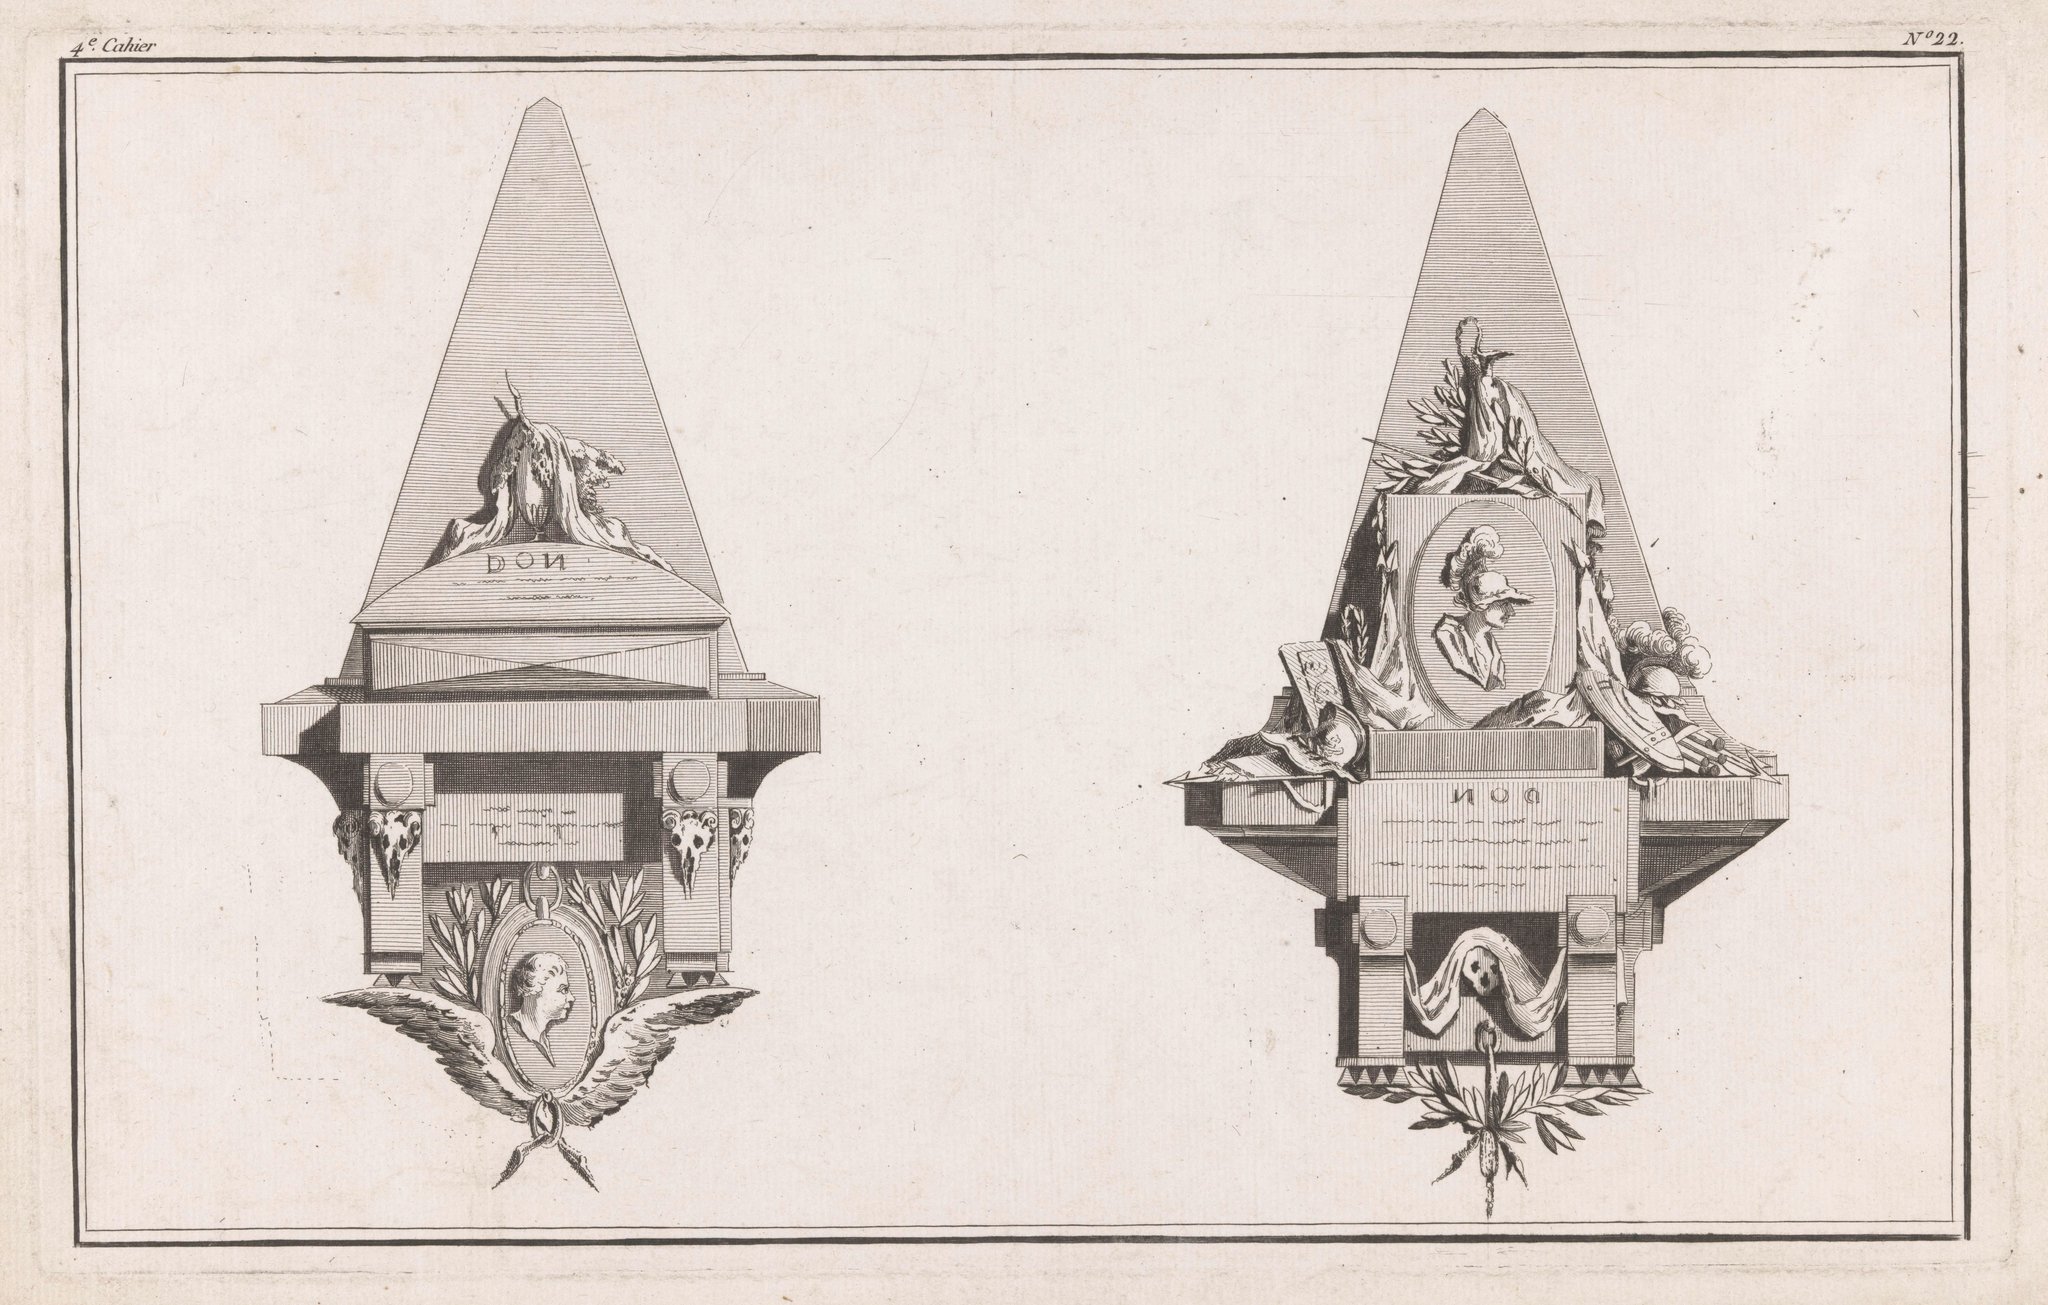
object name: print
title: IVe Cahier de Vases Boettes De Pendules Tombeaux &c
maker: jacques juillet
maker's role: print maker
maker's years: 1739-1784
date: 1777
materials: paper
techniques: etching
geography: paris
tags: ornament ~ medallion, grave, tomb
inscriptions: collector's mark: Lugt 2228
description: Links een tombe met obelisk, een vaas met draperieën, schedels en een gevleugeld medaillon met portret en profil. Rechts een tombe met obelisk, vaas met draperieën, wapens, een medaillon met portret en profil met helm en een schedel.